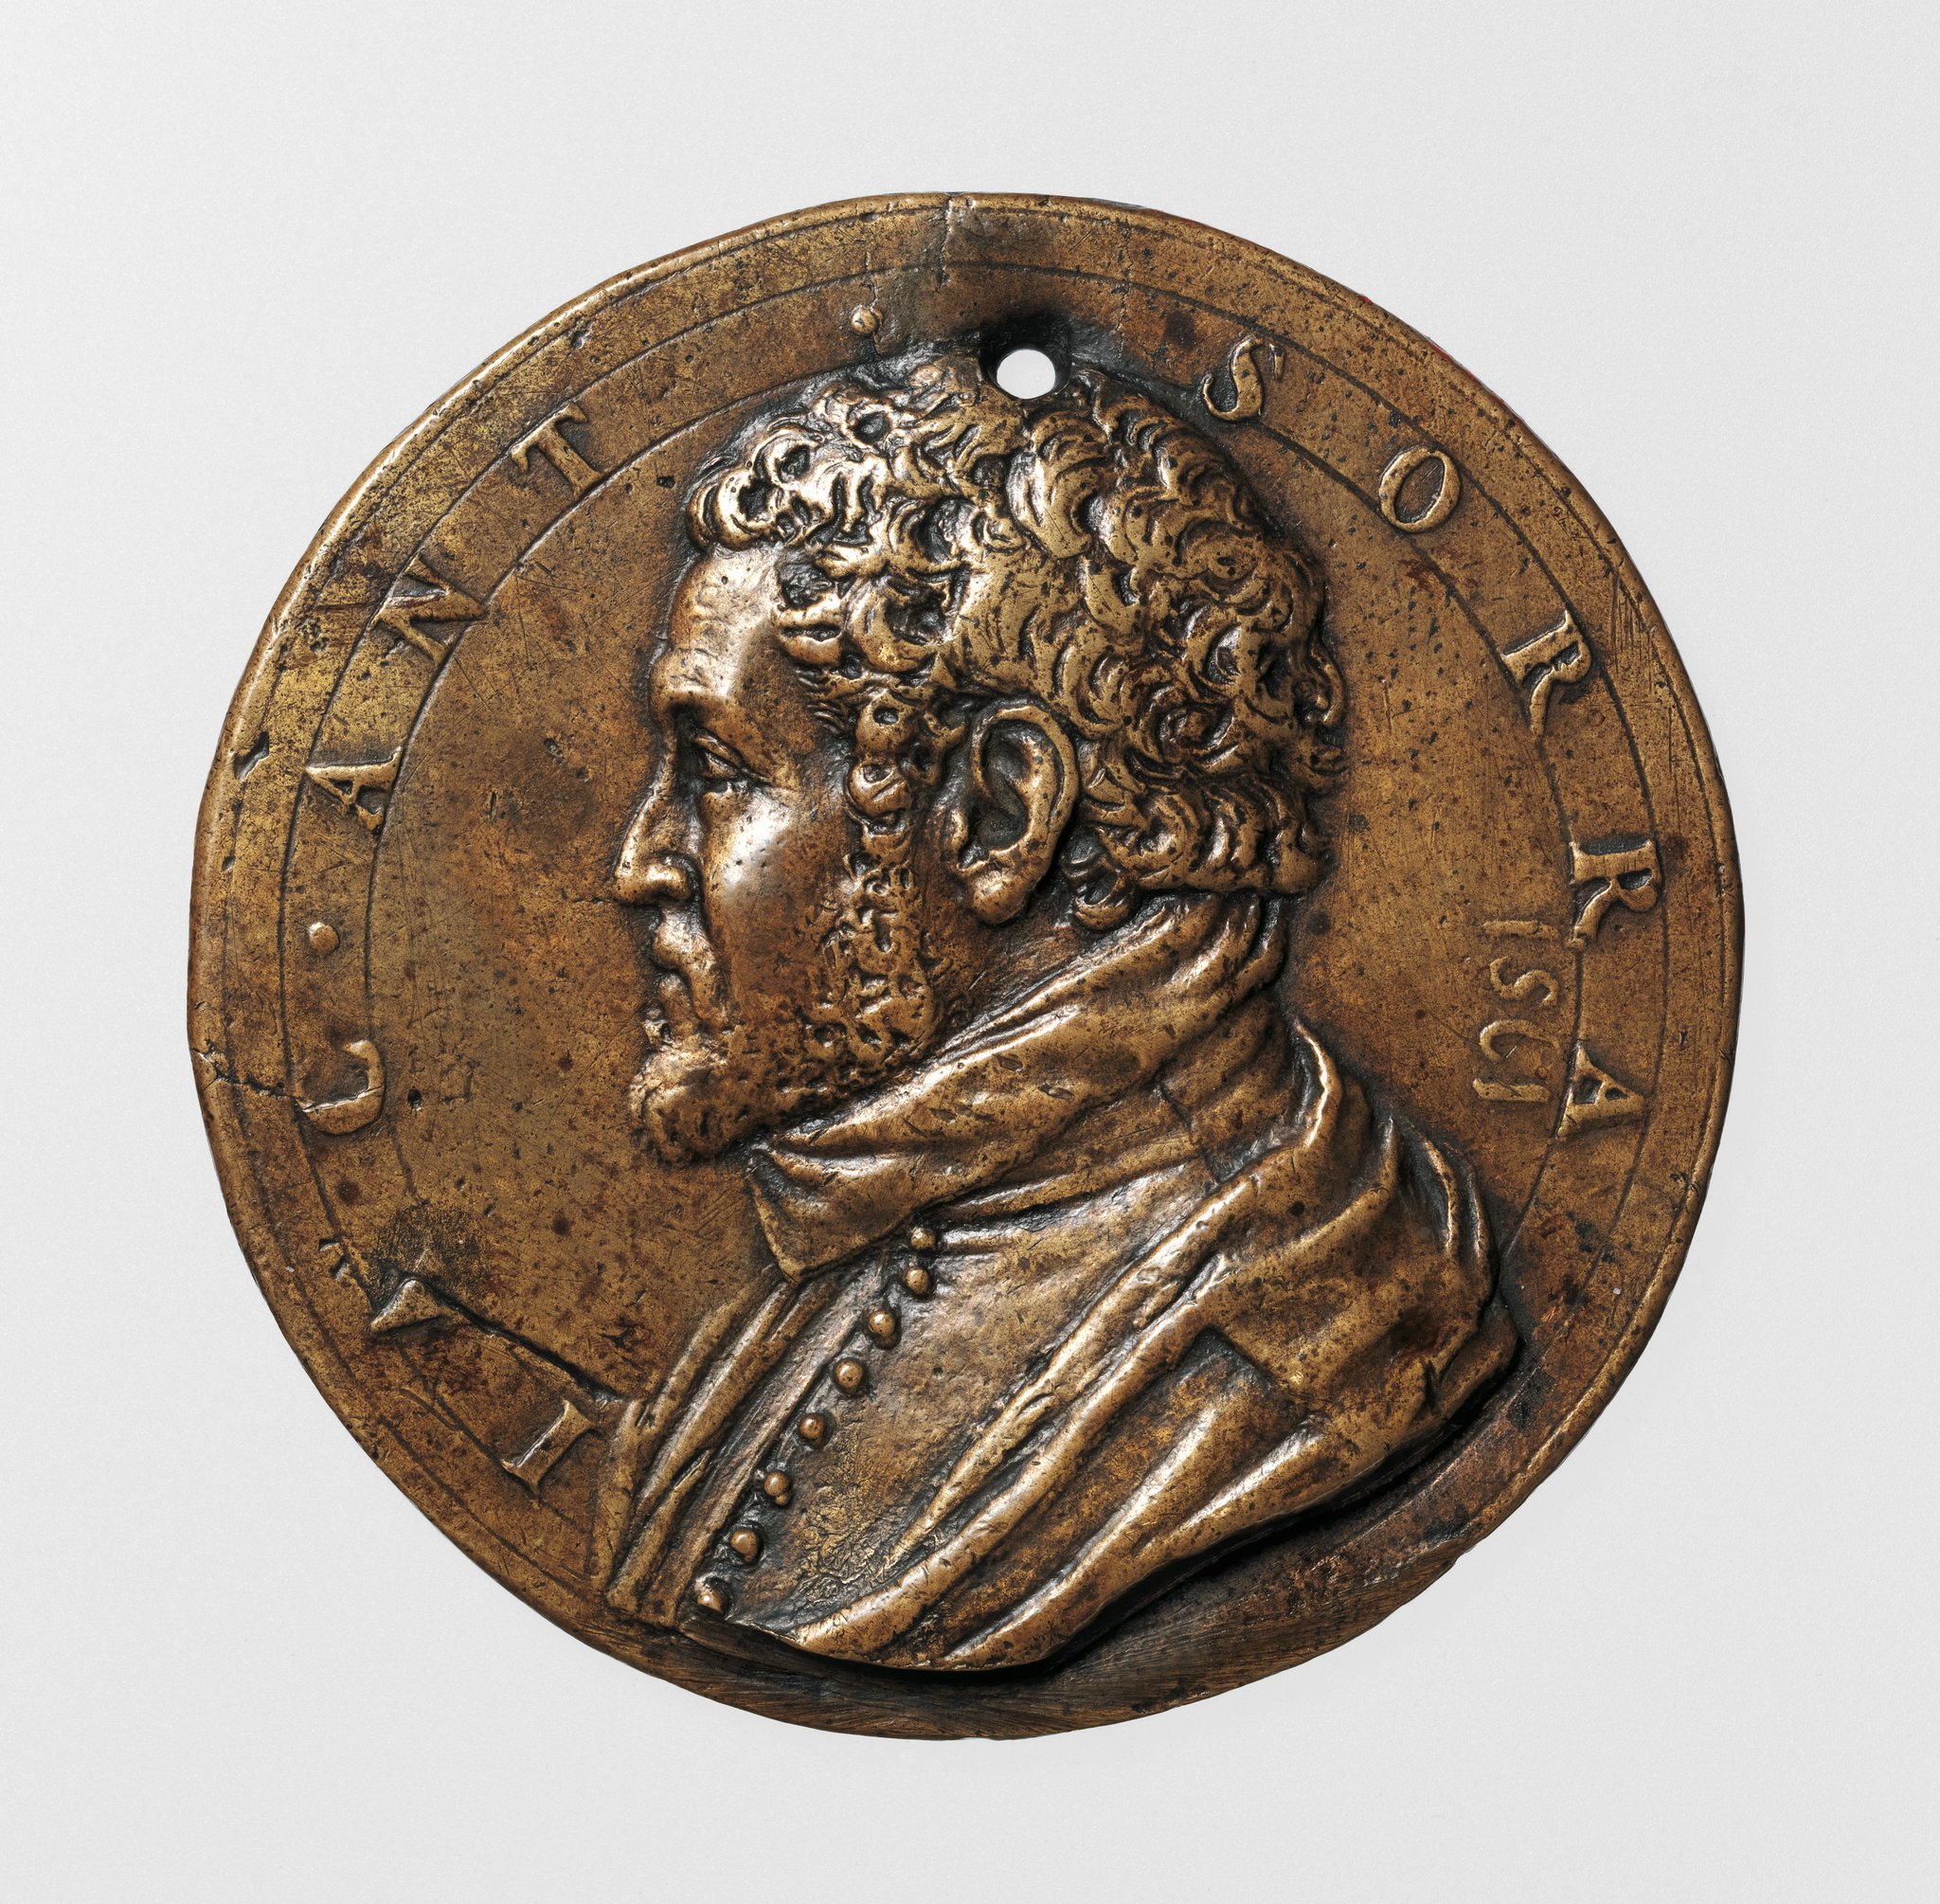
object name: medal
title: Portrait medal of Jacopo Antonio Sorra (obverse); A Nude Male Figure Shooting Arrows (reverse)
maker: antonio abondio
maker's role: artist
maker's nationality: italian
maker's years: 1538-1591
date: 1561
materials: bronze, copper alloy, patina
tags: bow and arrow,profiles,medals